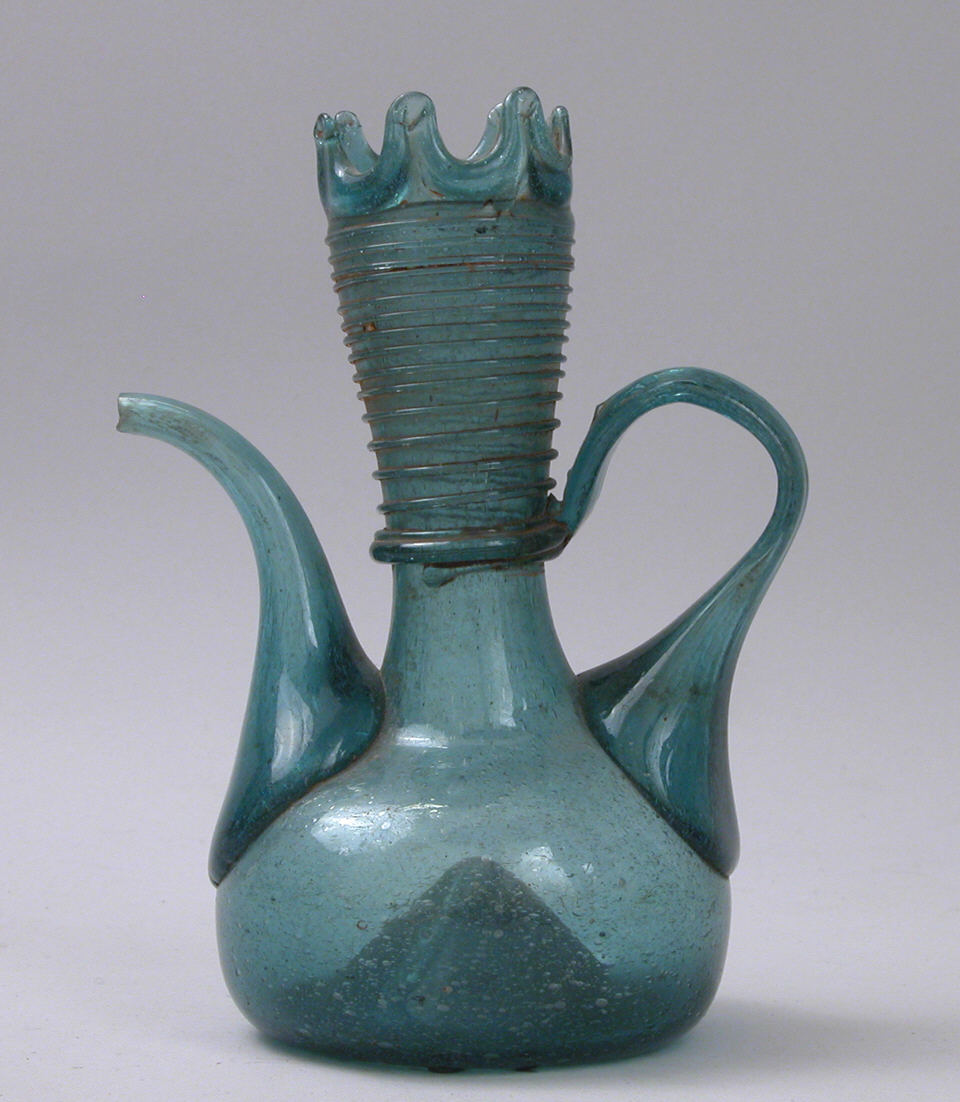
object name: ewer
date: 1701-1900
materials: glass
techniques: glassblowing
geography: iran